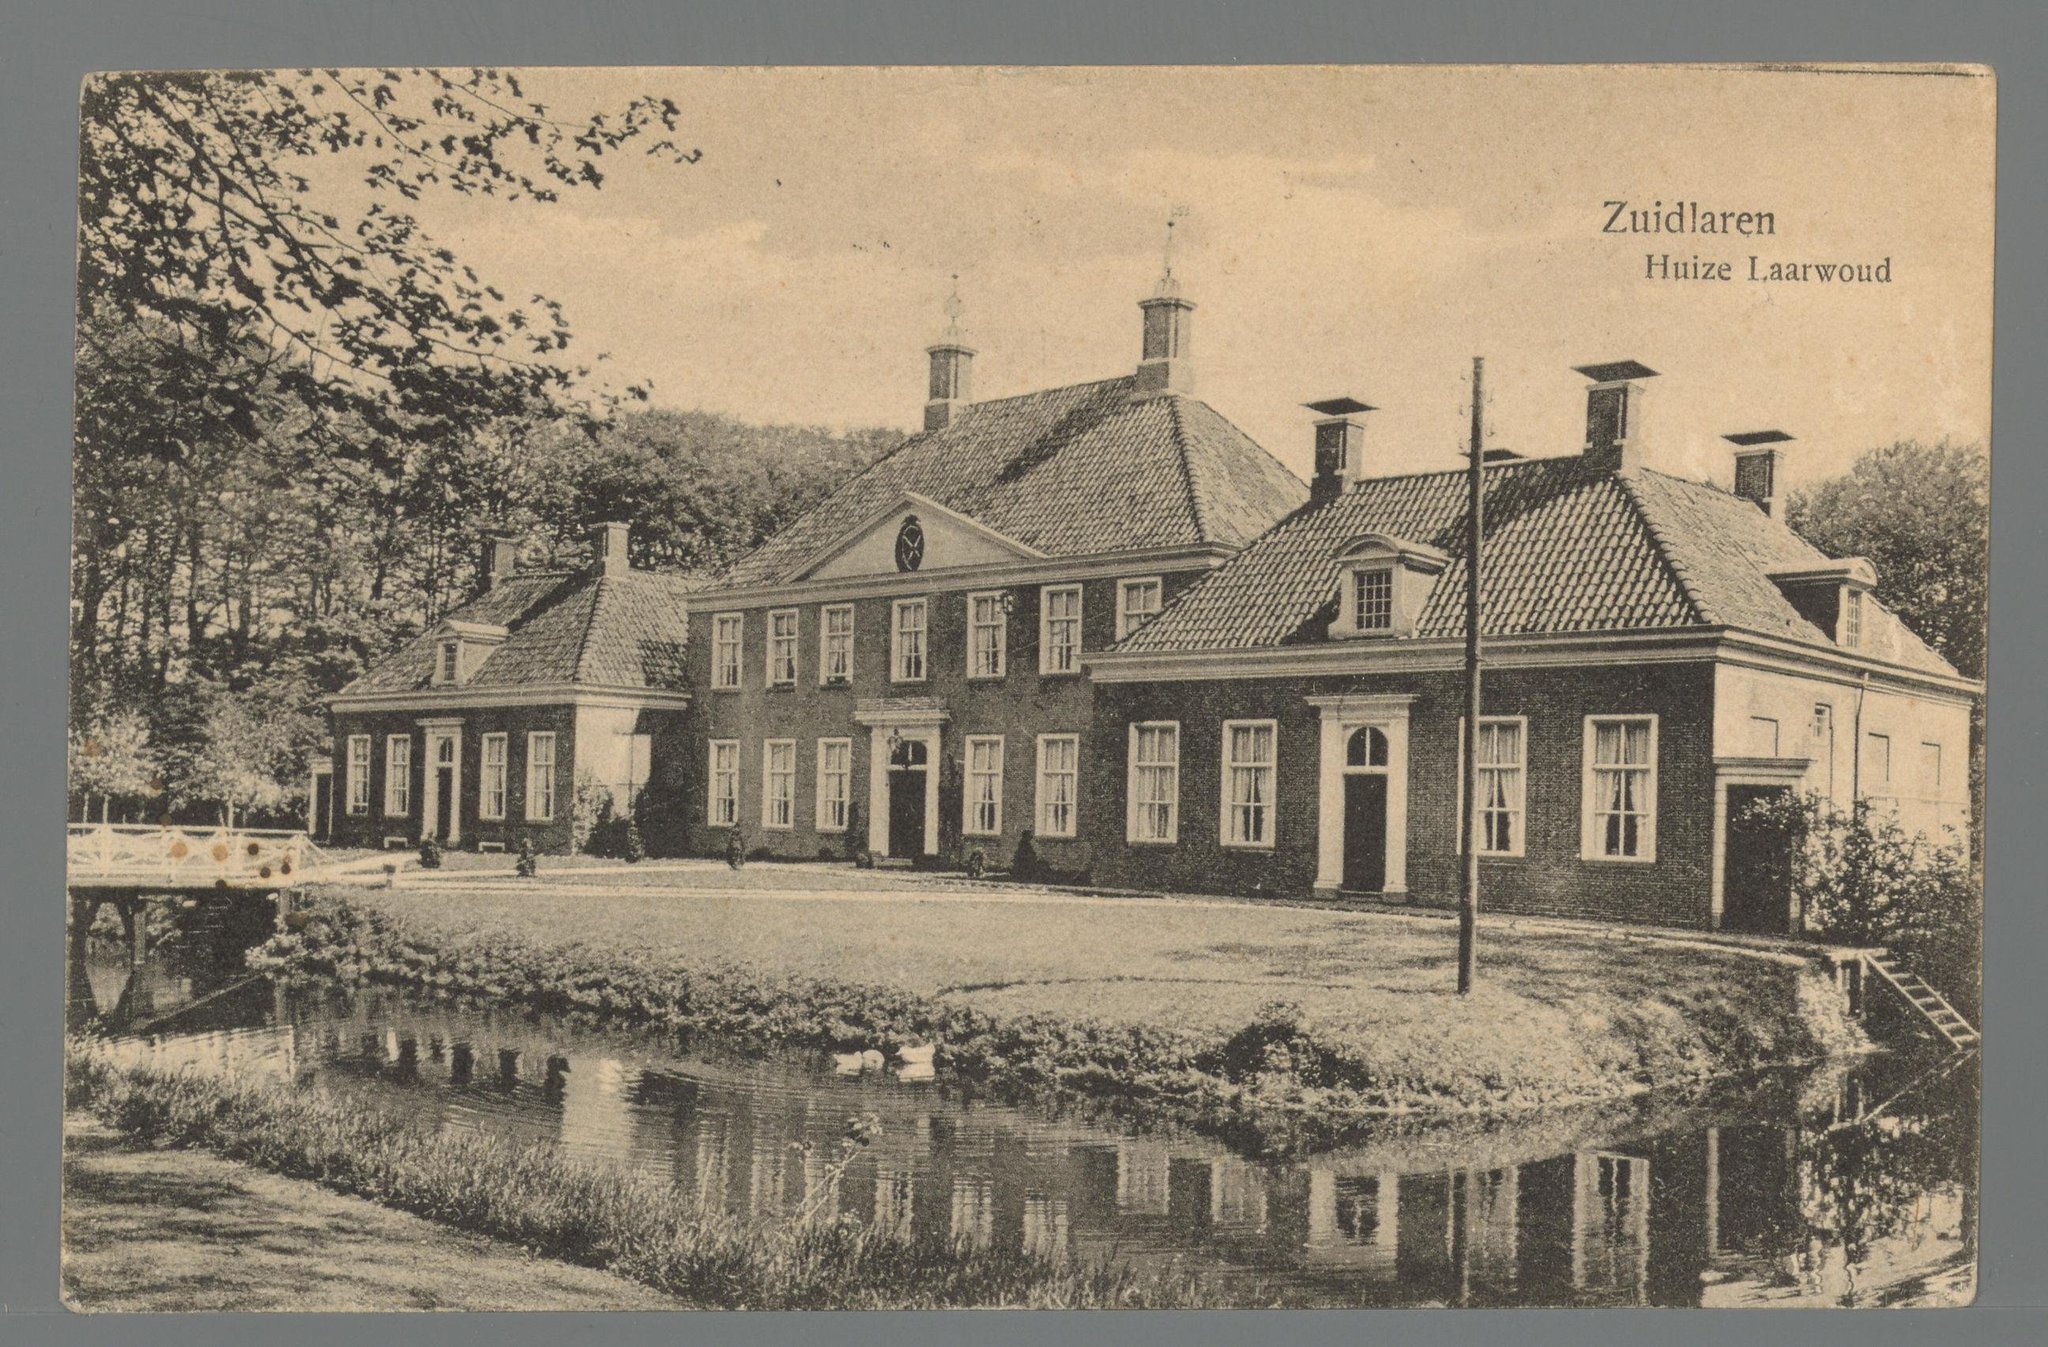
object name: photomechanical print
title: Zuidlaren. Huize Laarwoud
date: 1923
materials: cardboard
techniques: photograph, writing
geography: zuidlaren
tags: castle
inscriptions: postage stamp